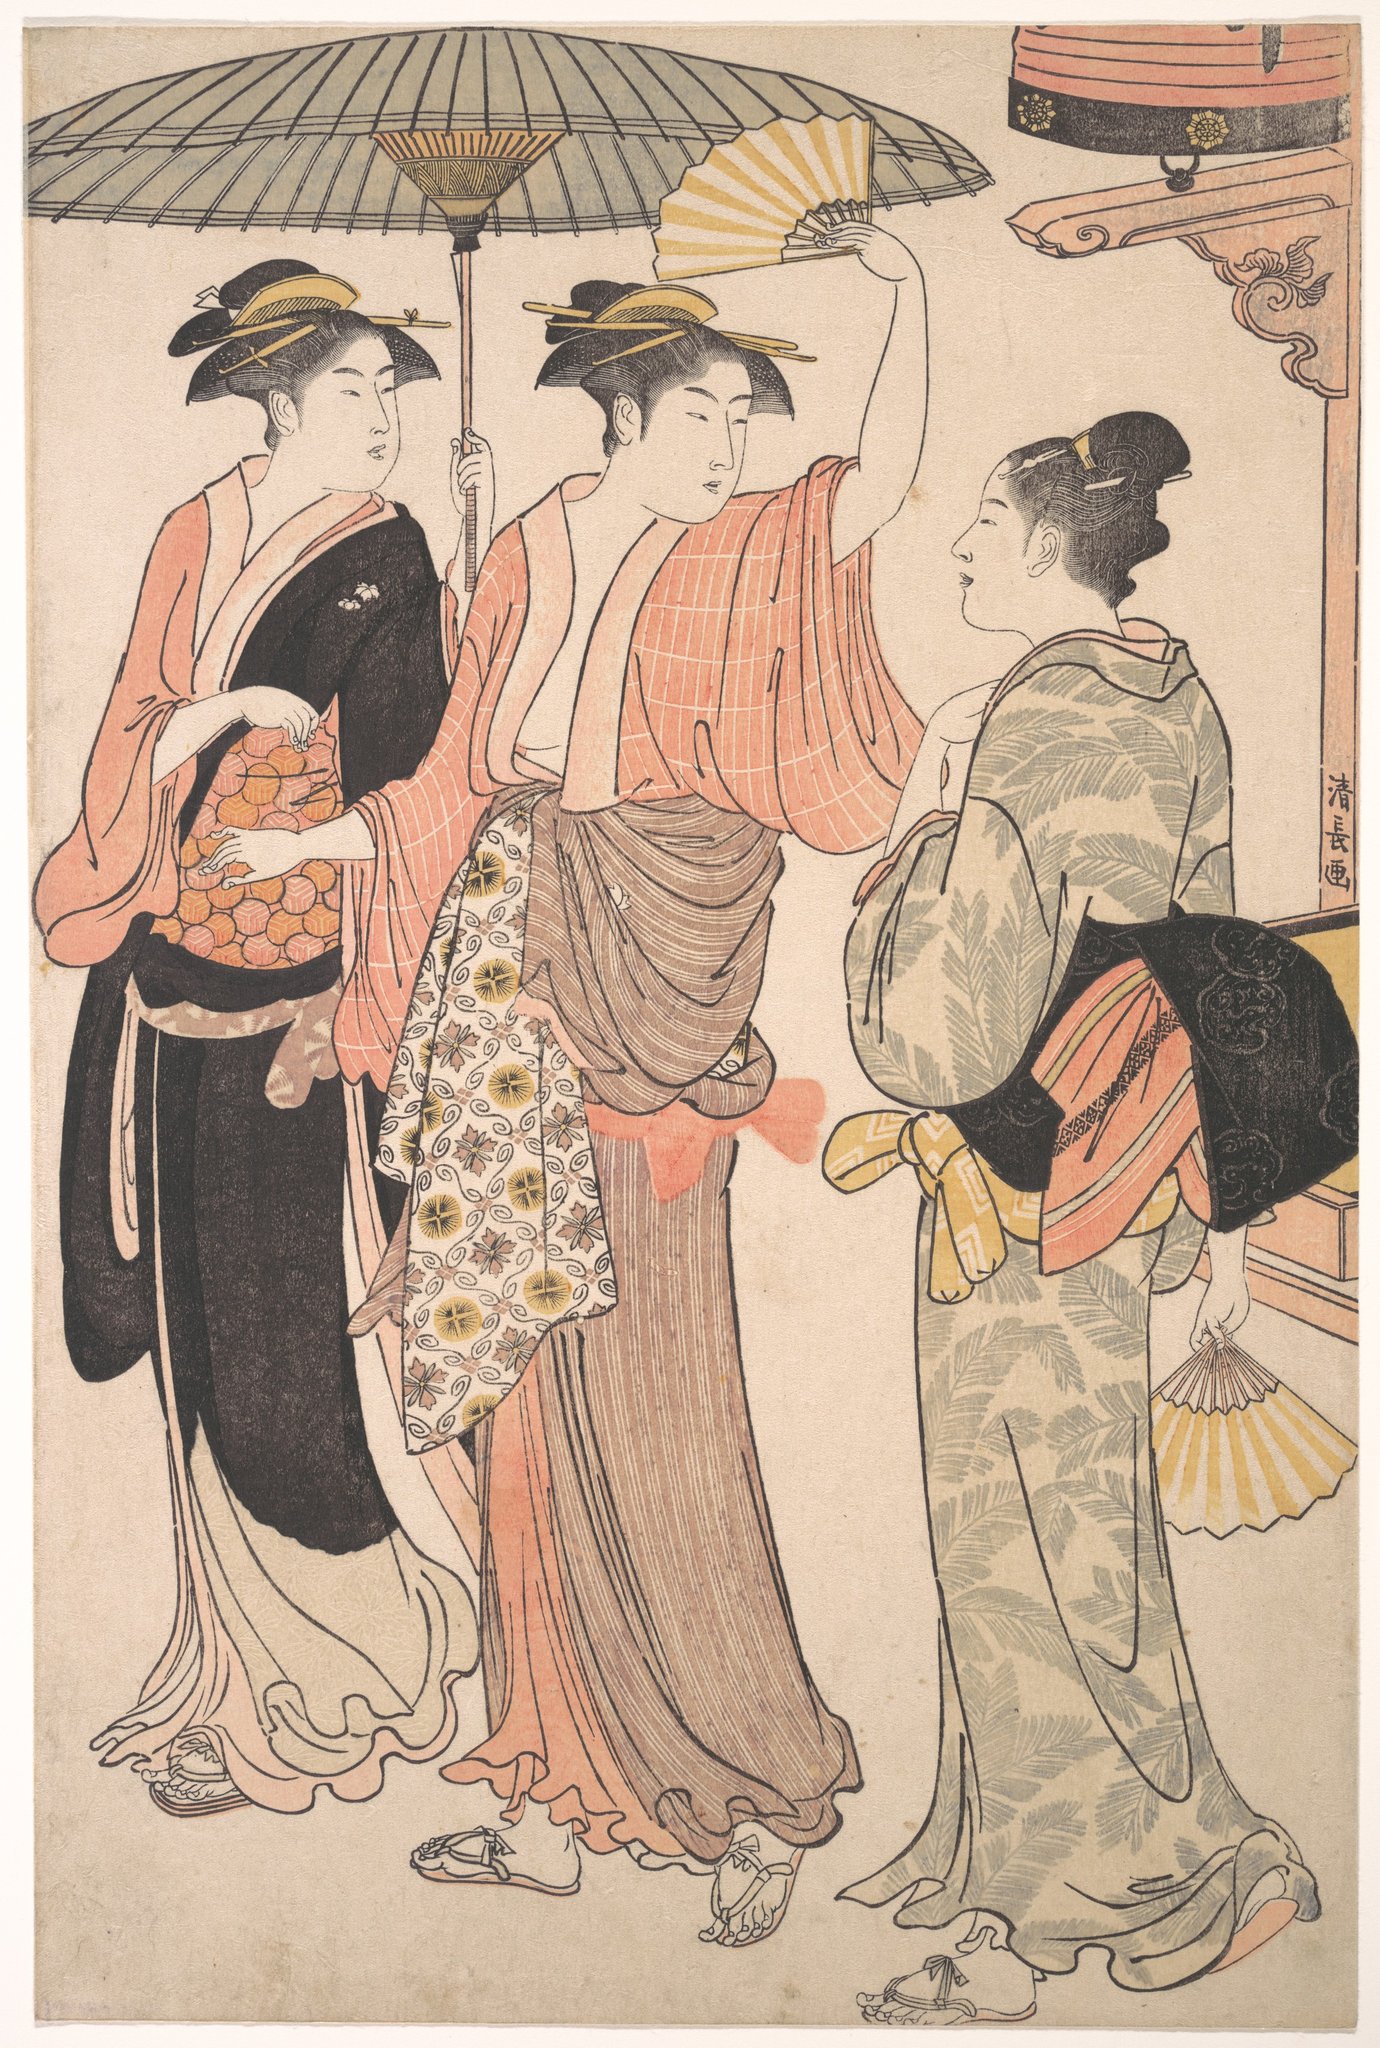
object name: print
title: The Fifth Month, from the series Twelve Months in the Southern Pleasure District (Minami jūni kō)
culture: japanese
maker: torii kiyonaga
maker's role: artist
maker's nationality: japanese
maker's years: 1752-1815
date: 1784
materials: ink, paper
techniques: woodblock print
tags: fans,women